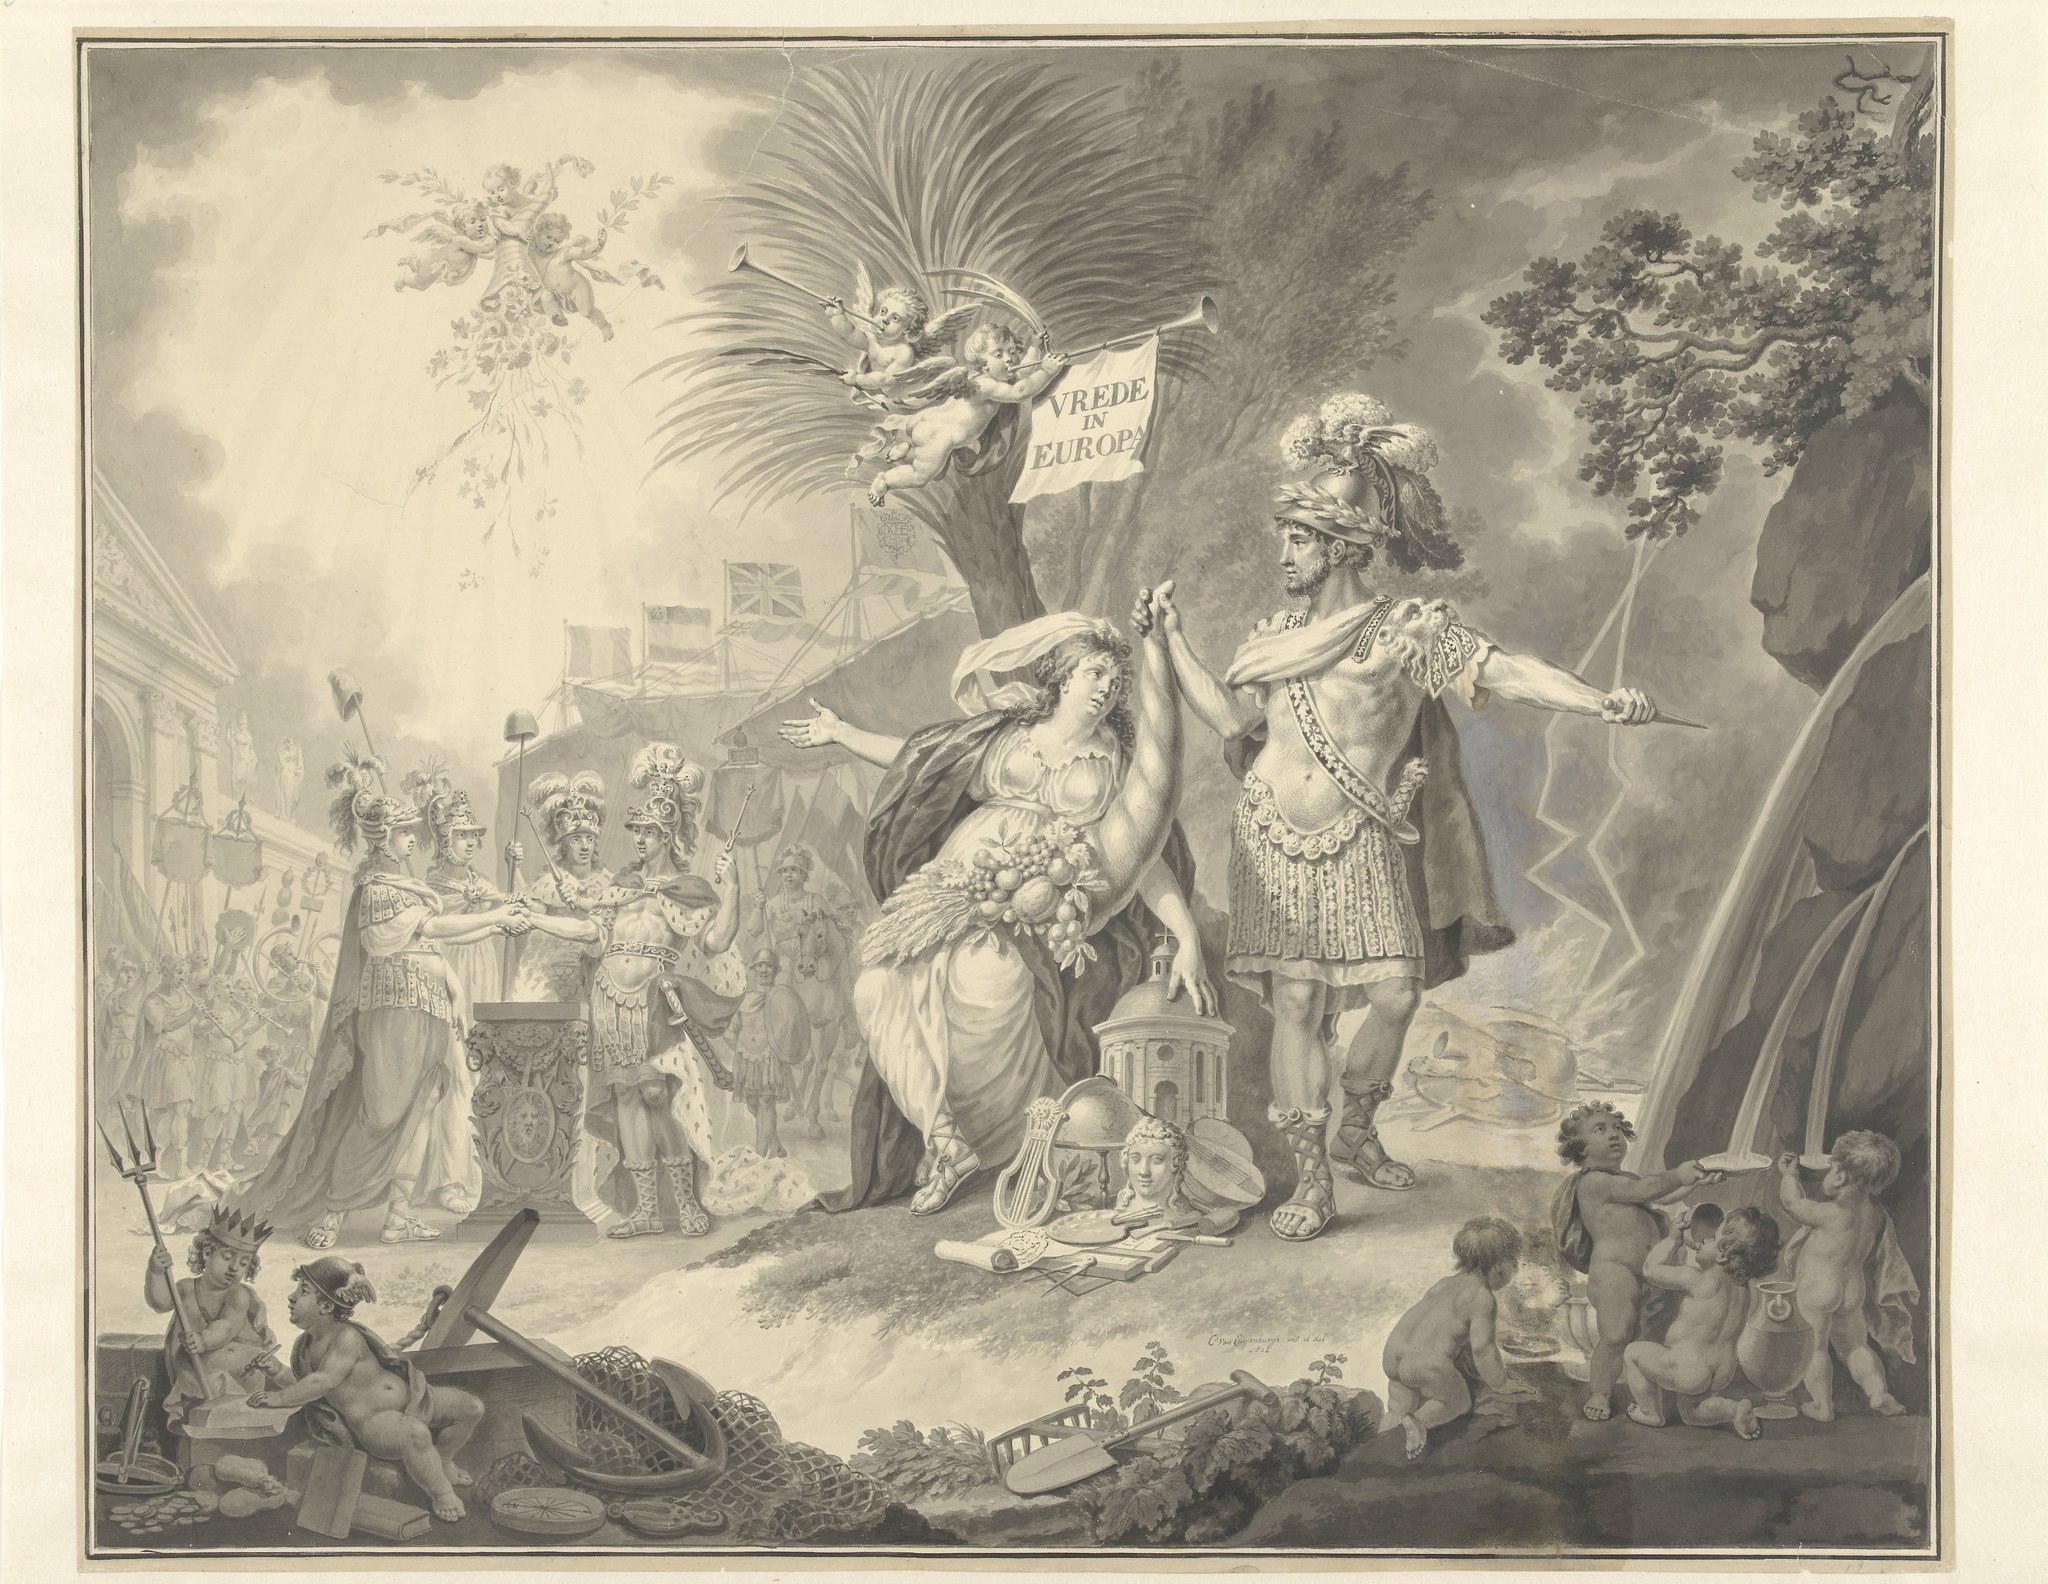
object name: drawing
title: Zinneprent op de Vrede van 1802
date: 1802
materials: chalk, paint, paper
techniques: brush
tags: symbols, allegories of peace, 'pax'; 'pace' (ripa), signing of peace treaty, concluding the peace, historical events and situations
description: Niet in Frederik Muller; door het RPK toegevoegd nummer.